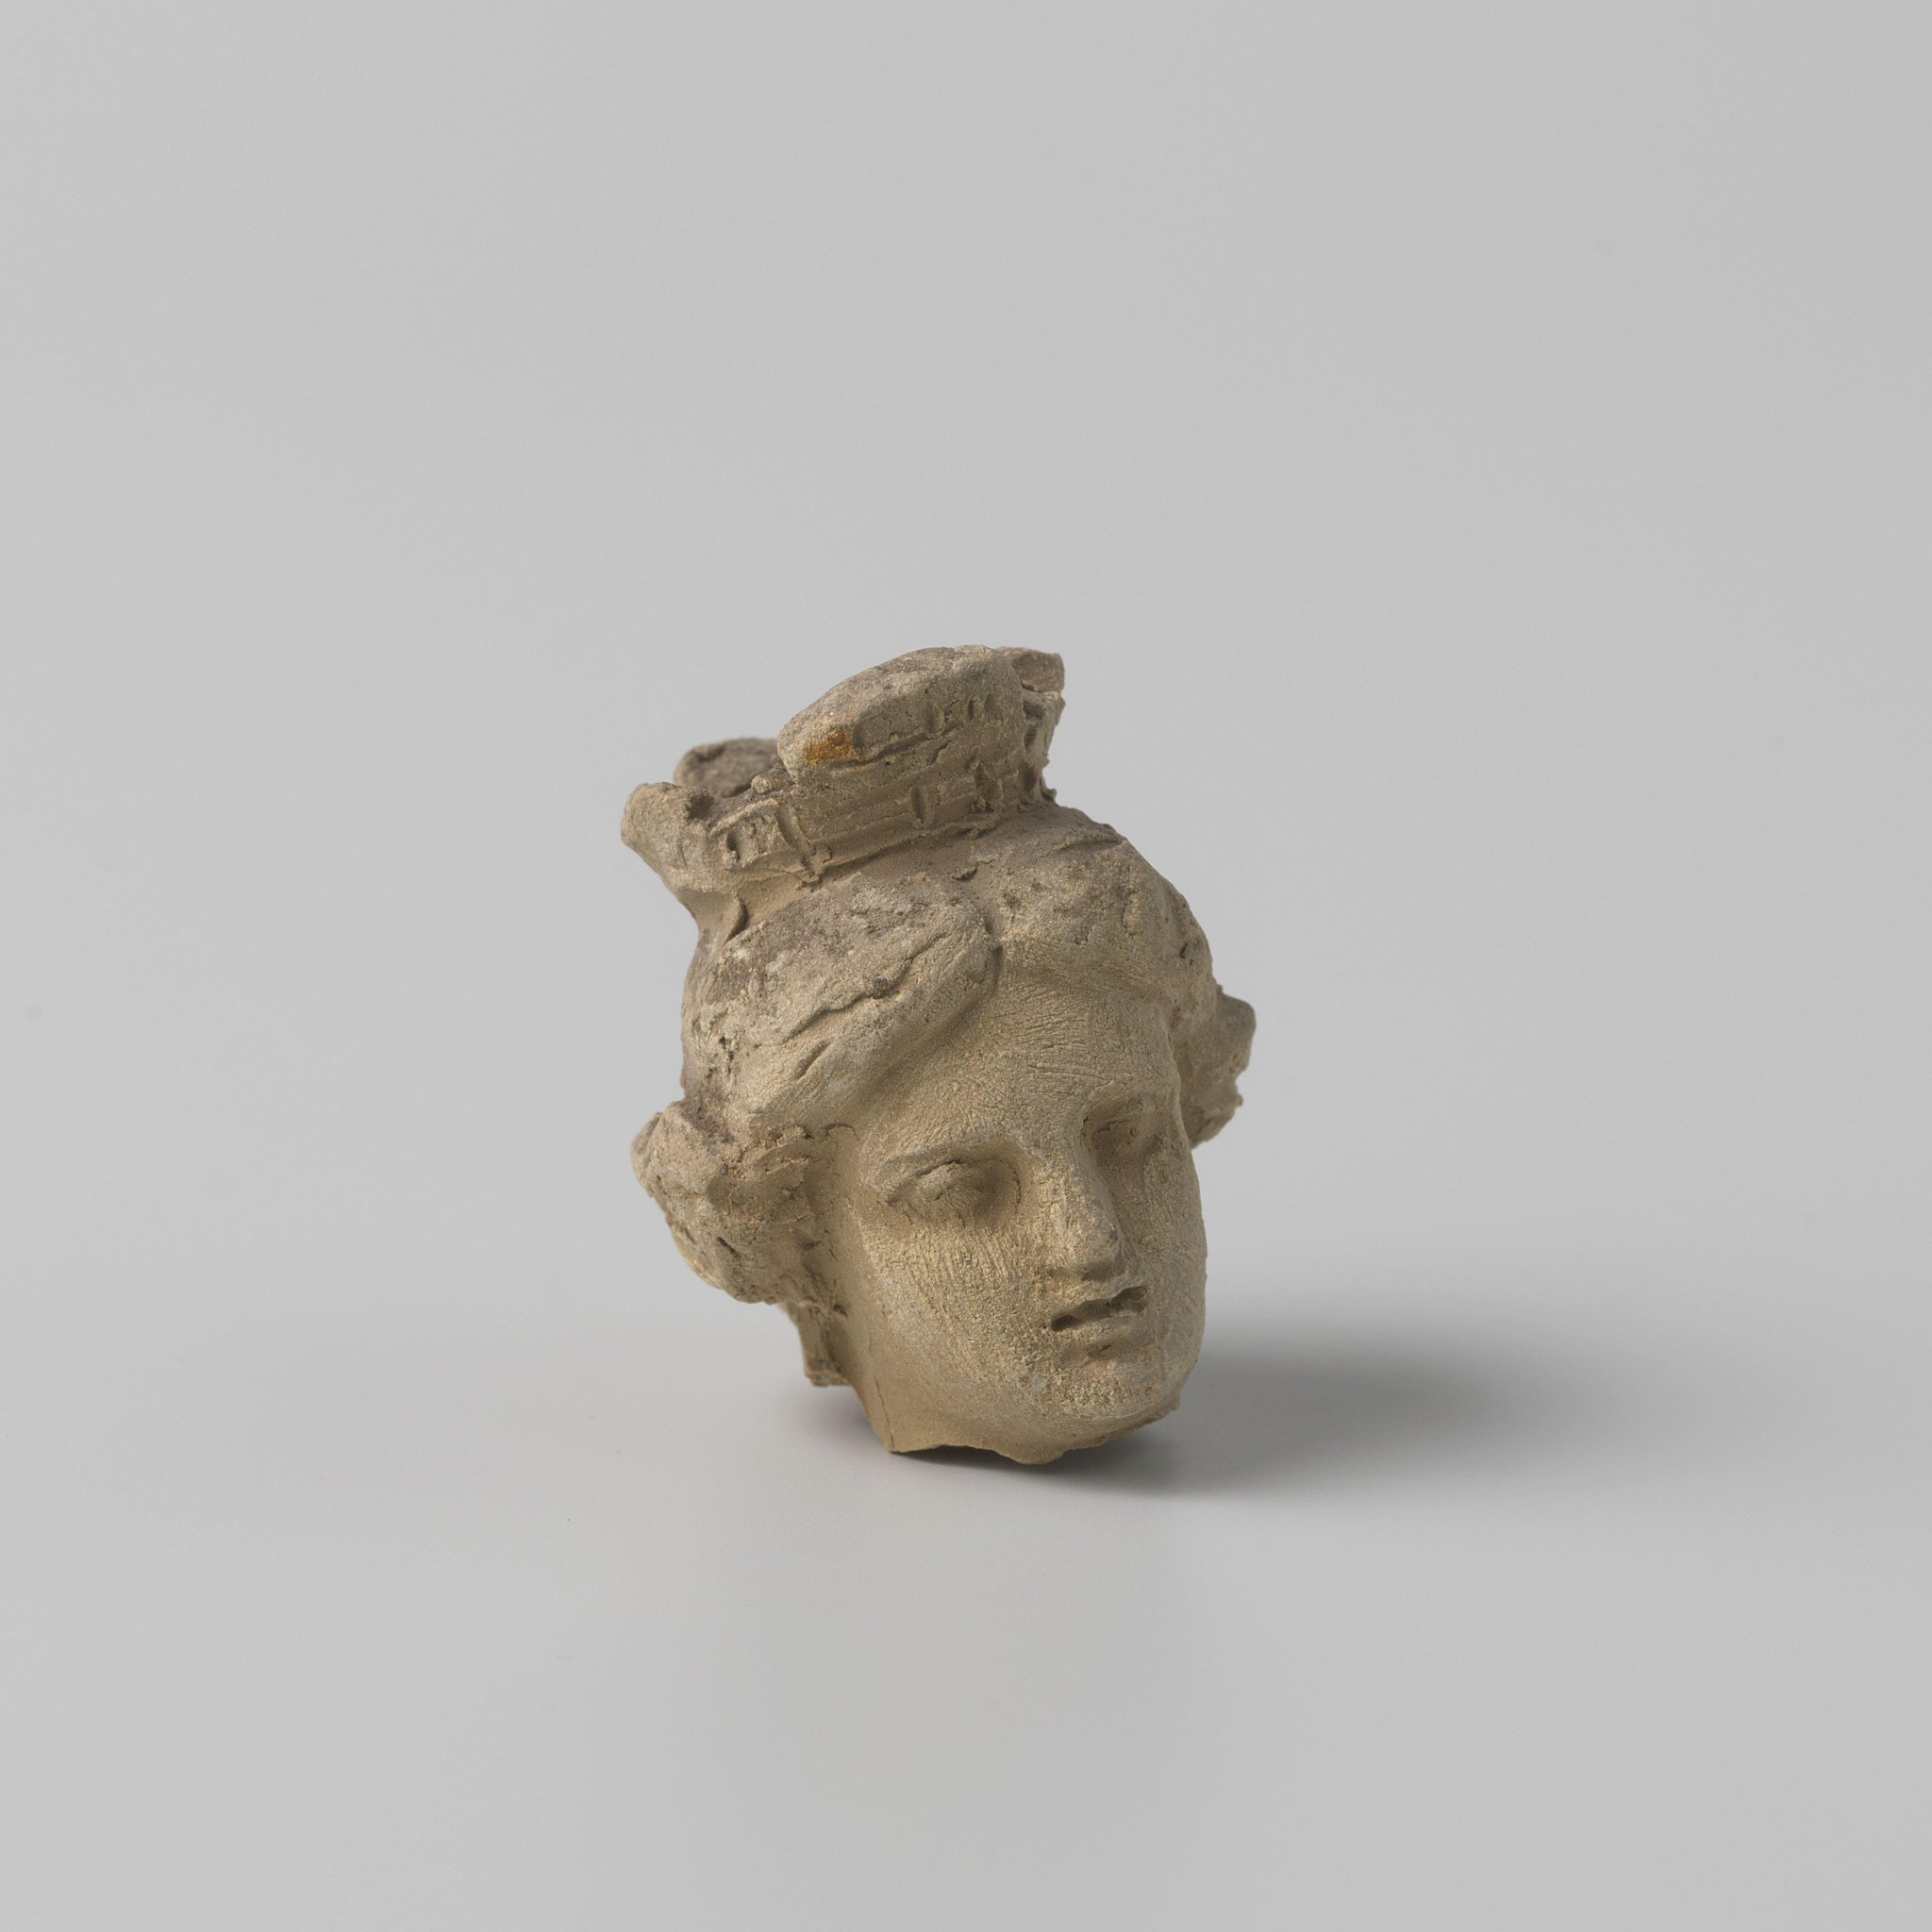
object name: sculpture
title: Onderdeel van Synagoge (?)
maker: eugène lacomblé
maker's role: draughtsman, painter, sculptor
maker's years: 1828-1905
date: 1828-1905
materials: clay